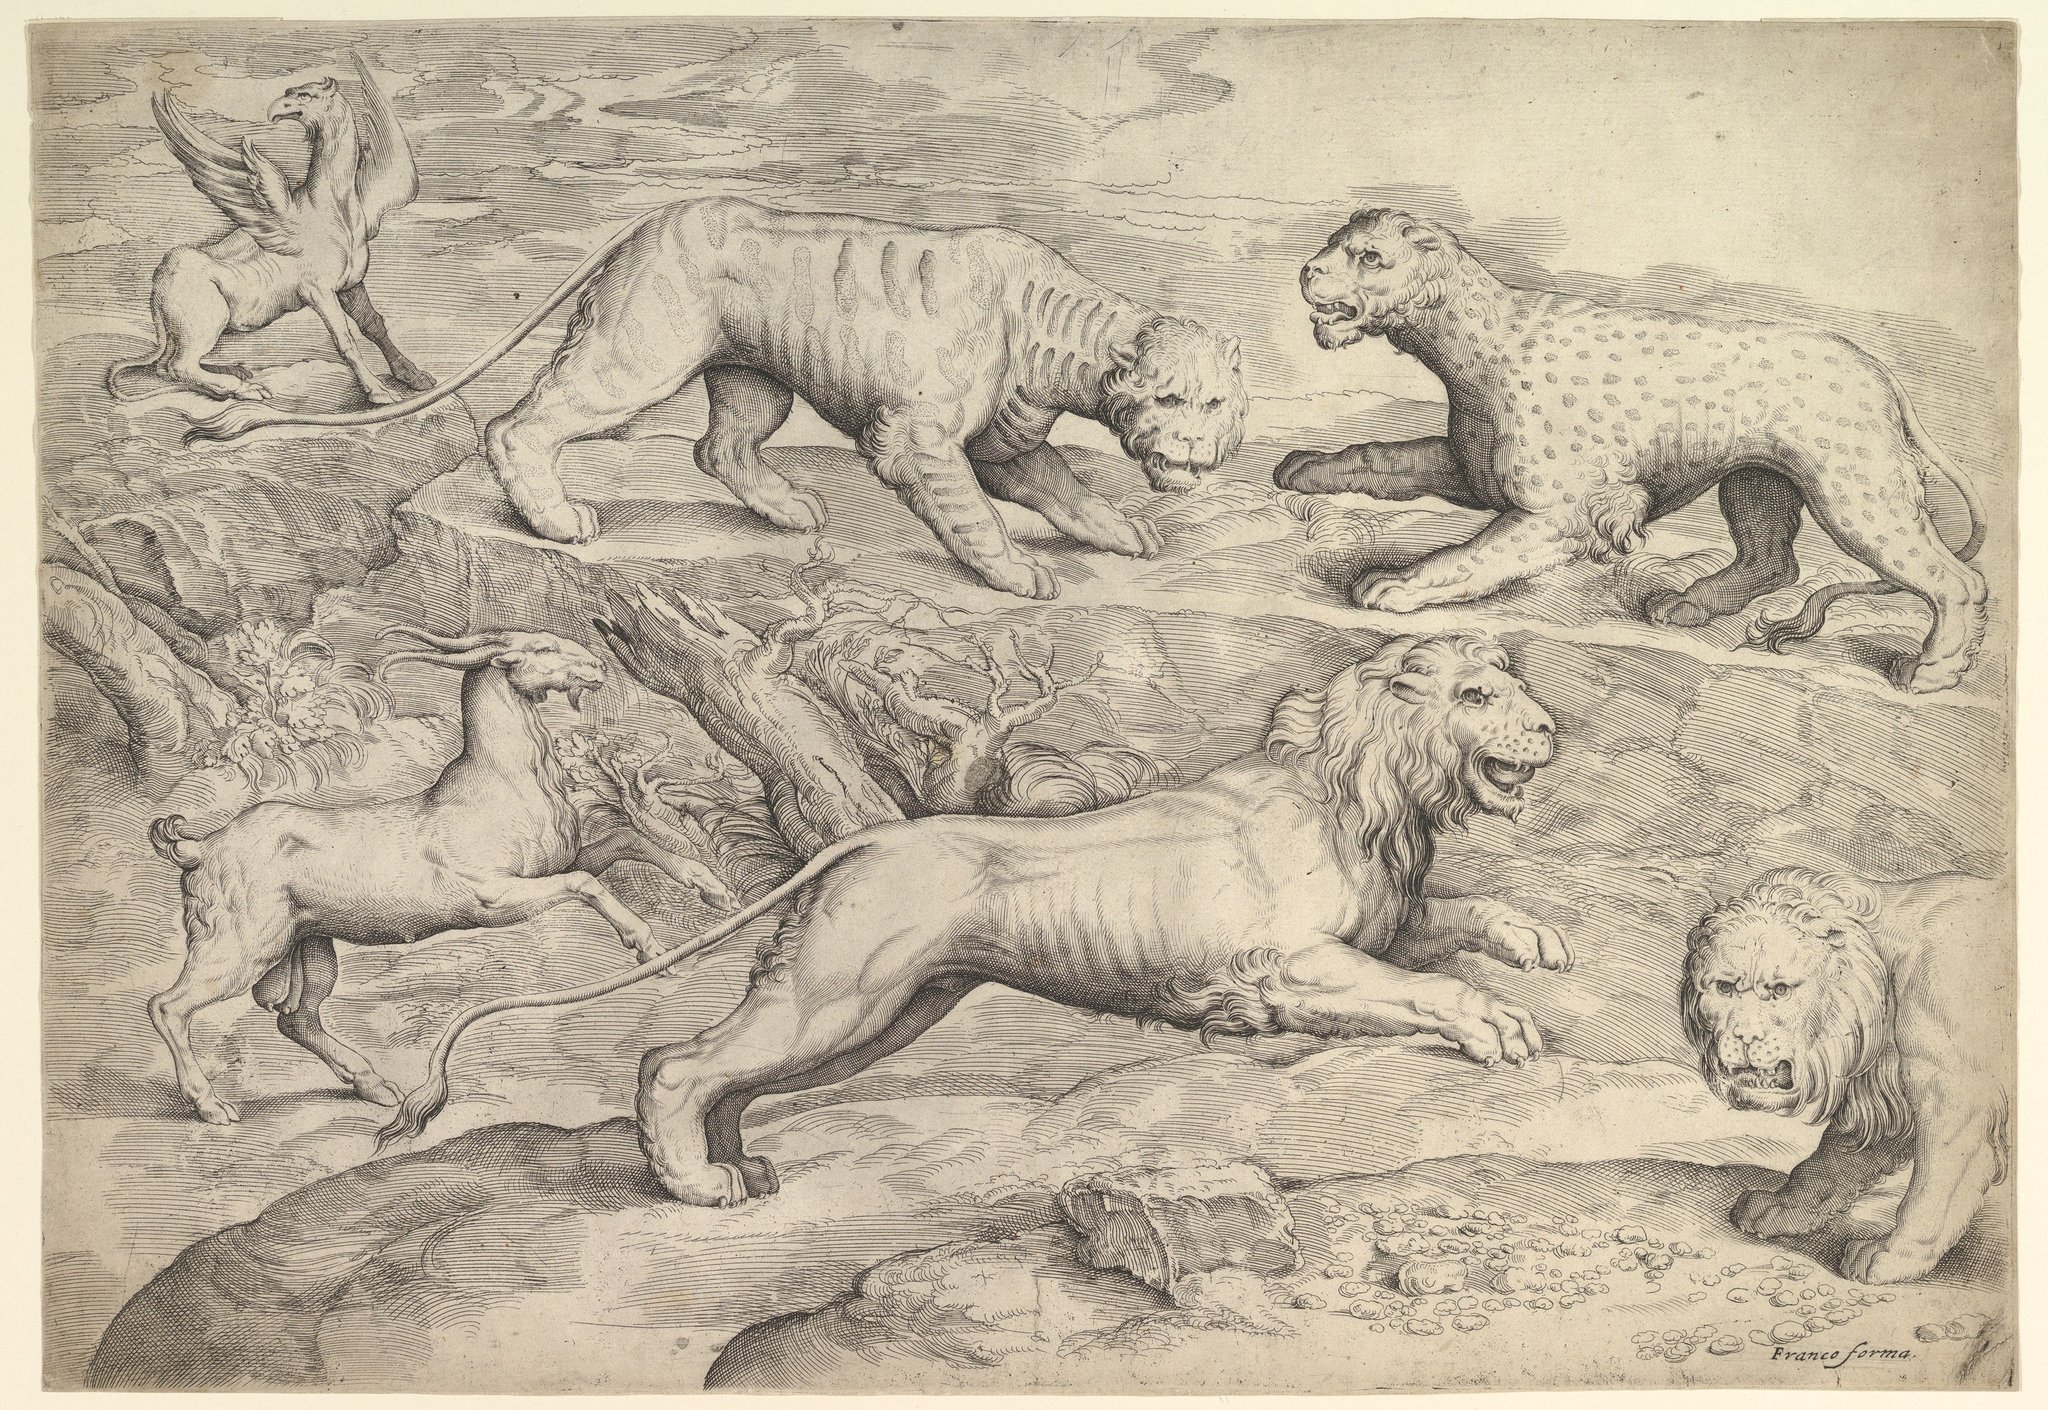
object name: print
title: Six Animals, including lions, a tiger, a leopard, a griffin, and a goat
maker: battista franco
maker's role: artist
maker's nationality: italian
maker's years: 1510-1561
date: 1530-1561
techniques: engraving, etching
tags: griffins,goats,leopards,lions,tigers